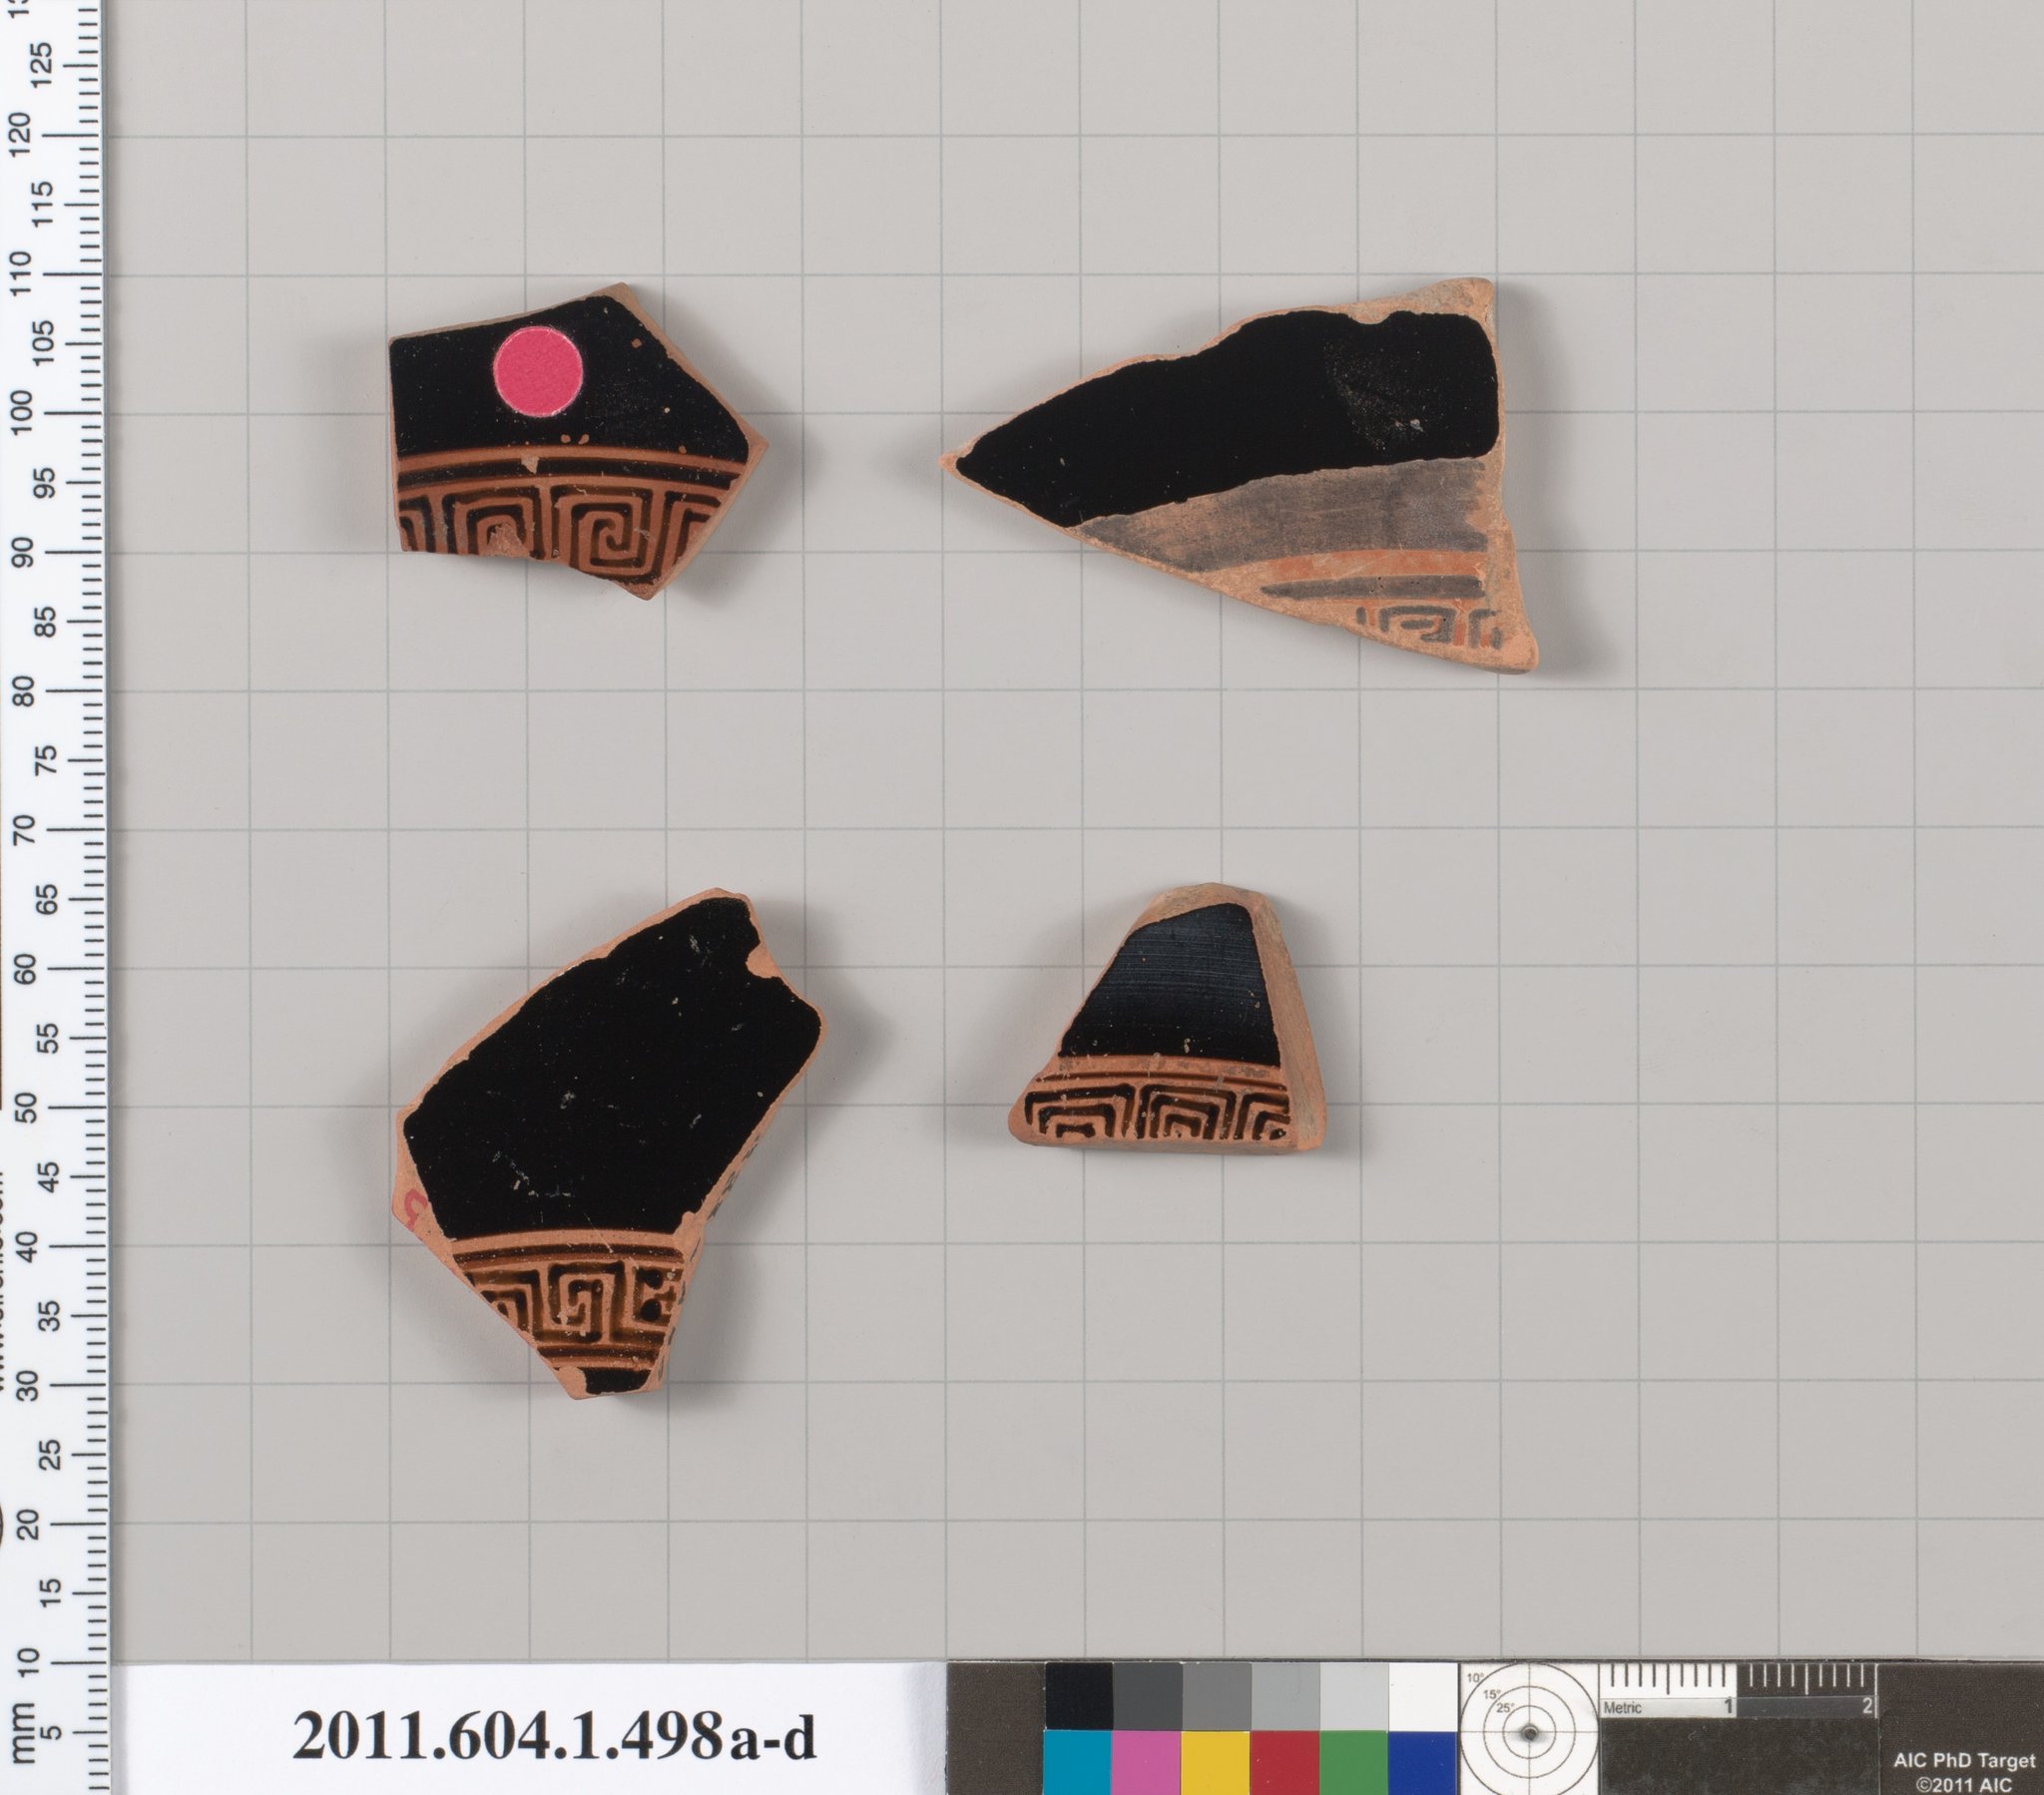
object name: kylix fragment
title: Terracotta fragments of kylikes (drinking cups)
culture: greek, attic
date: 490-480 BCE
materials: terracotta